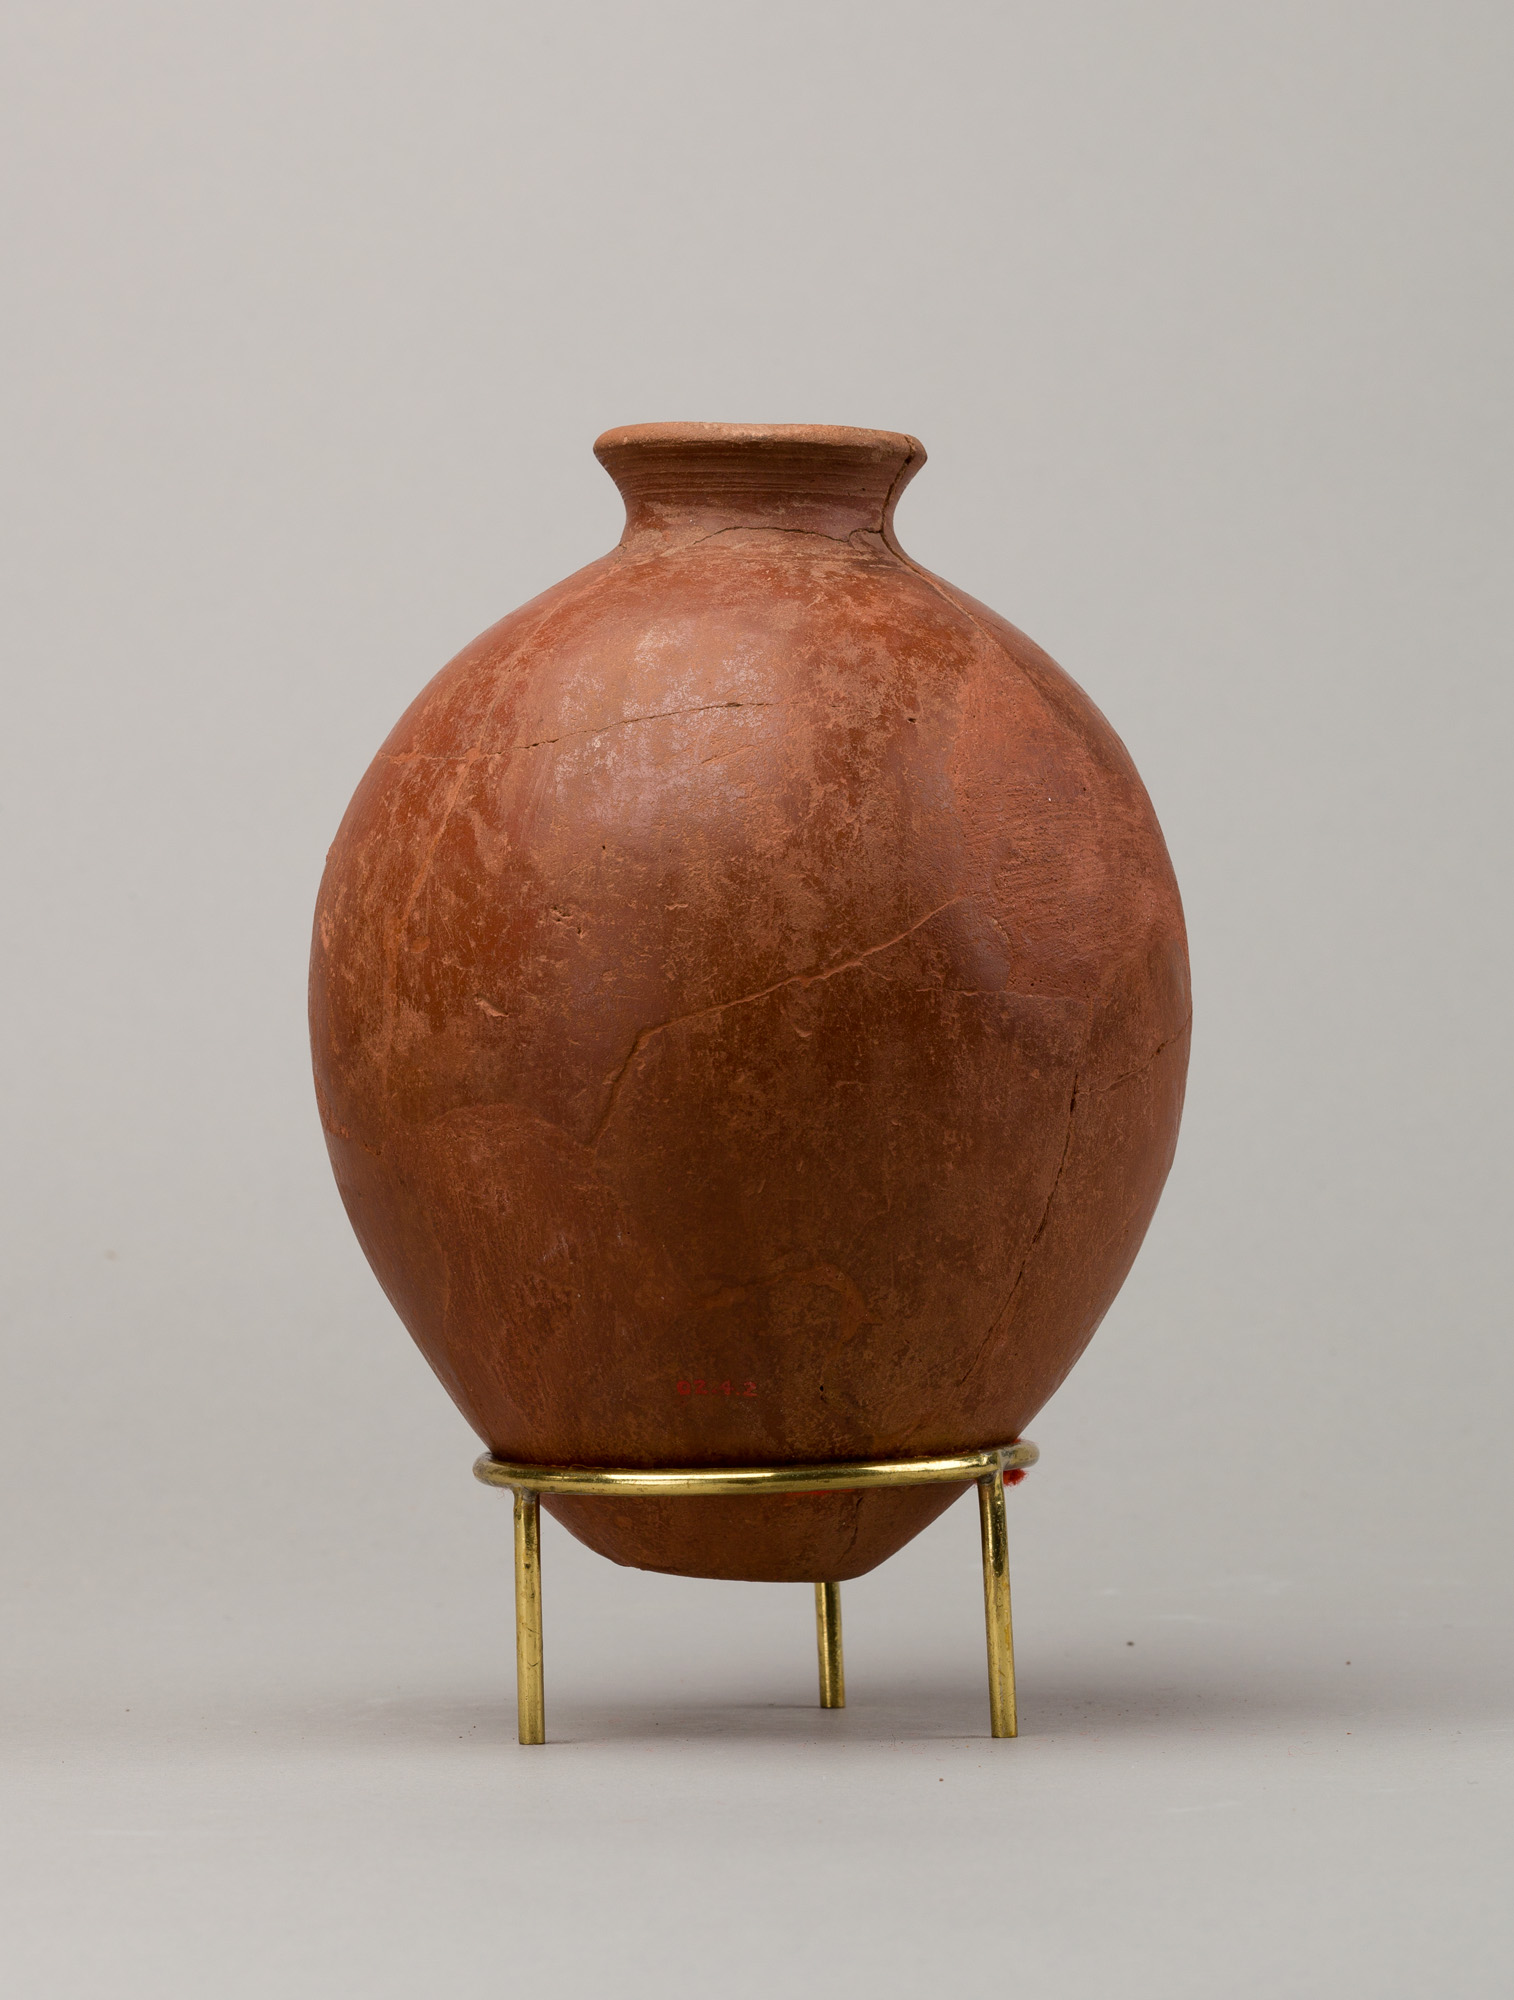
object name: jar, red polished ware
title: Red polish ware jar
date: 4500-4000 BCE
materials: pottery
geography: egypt